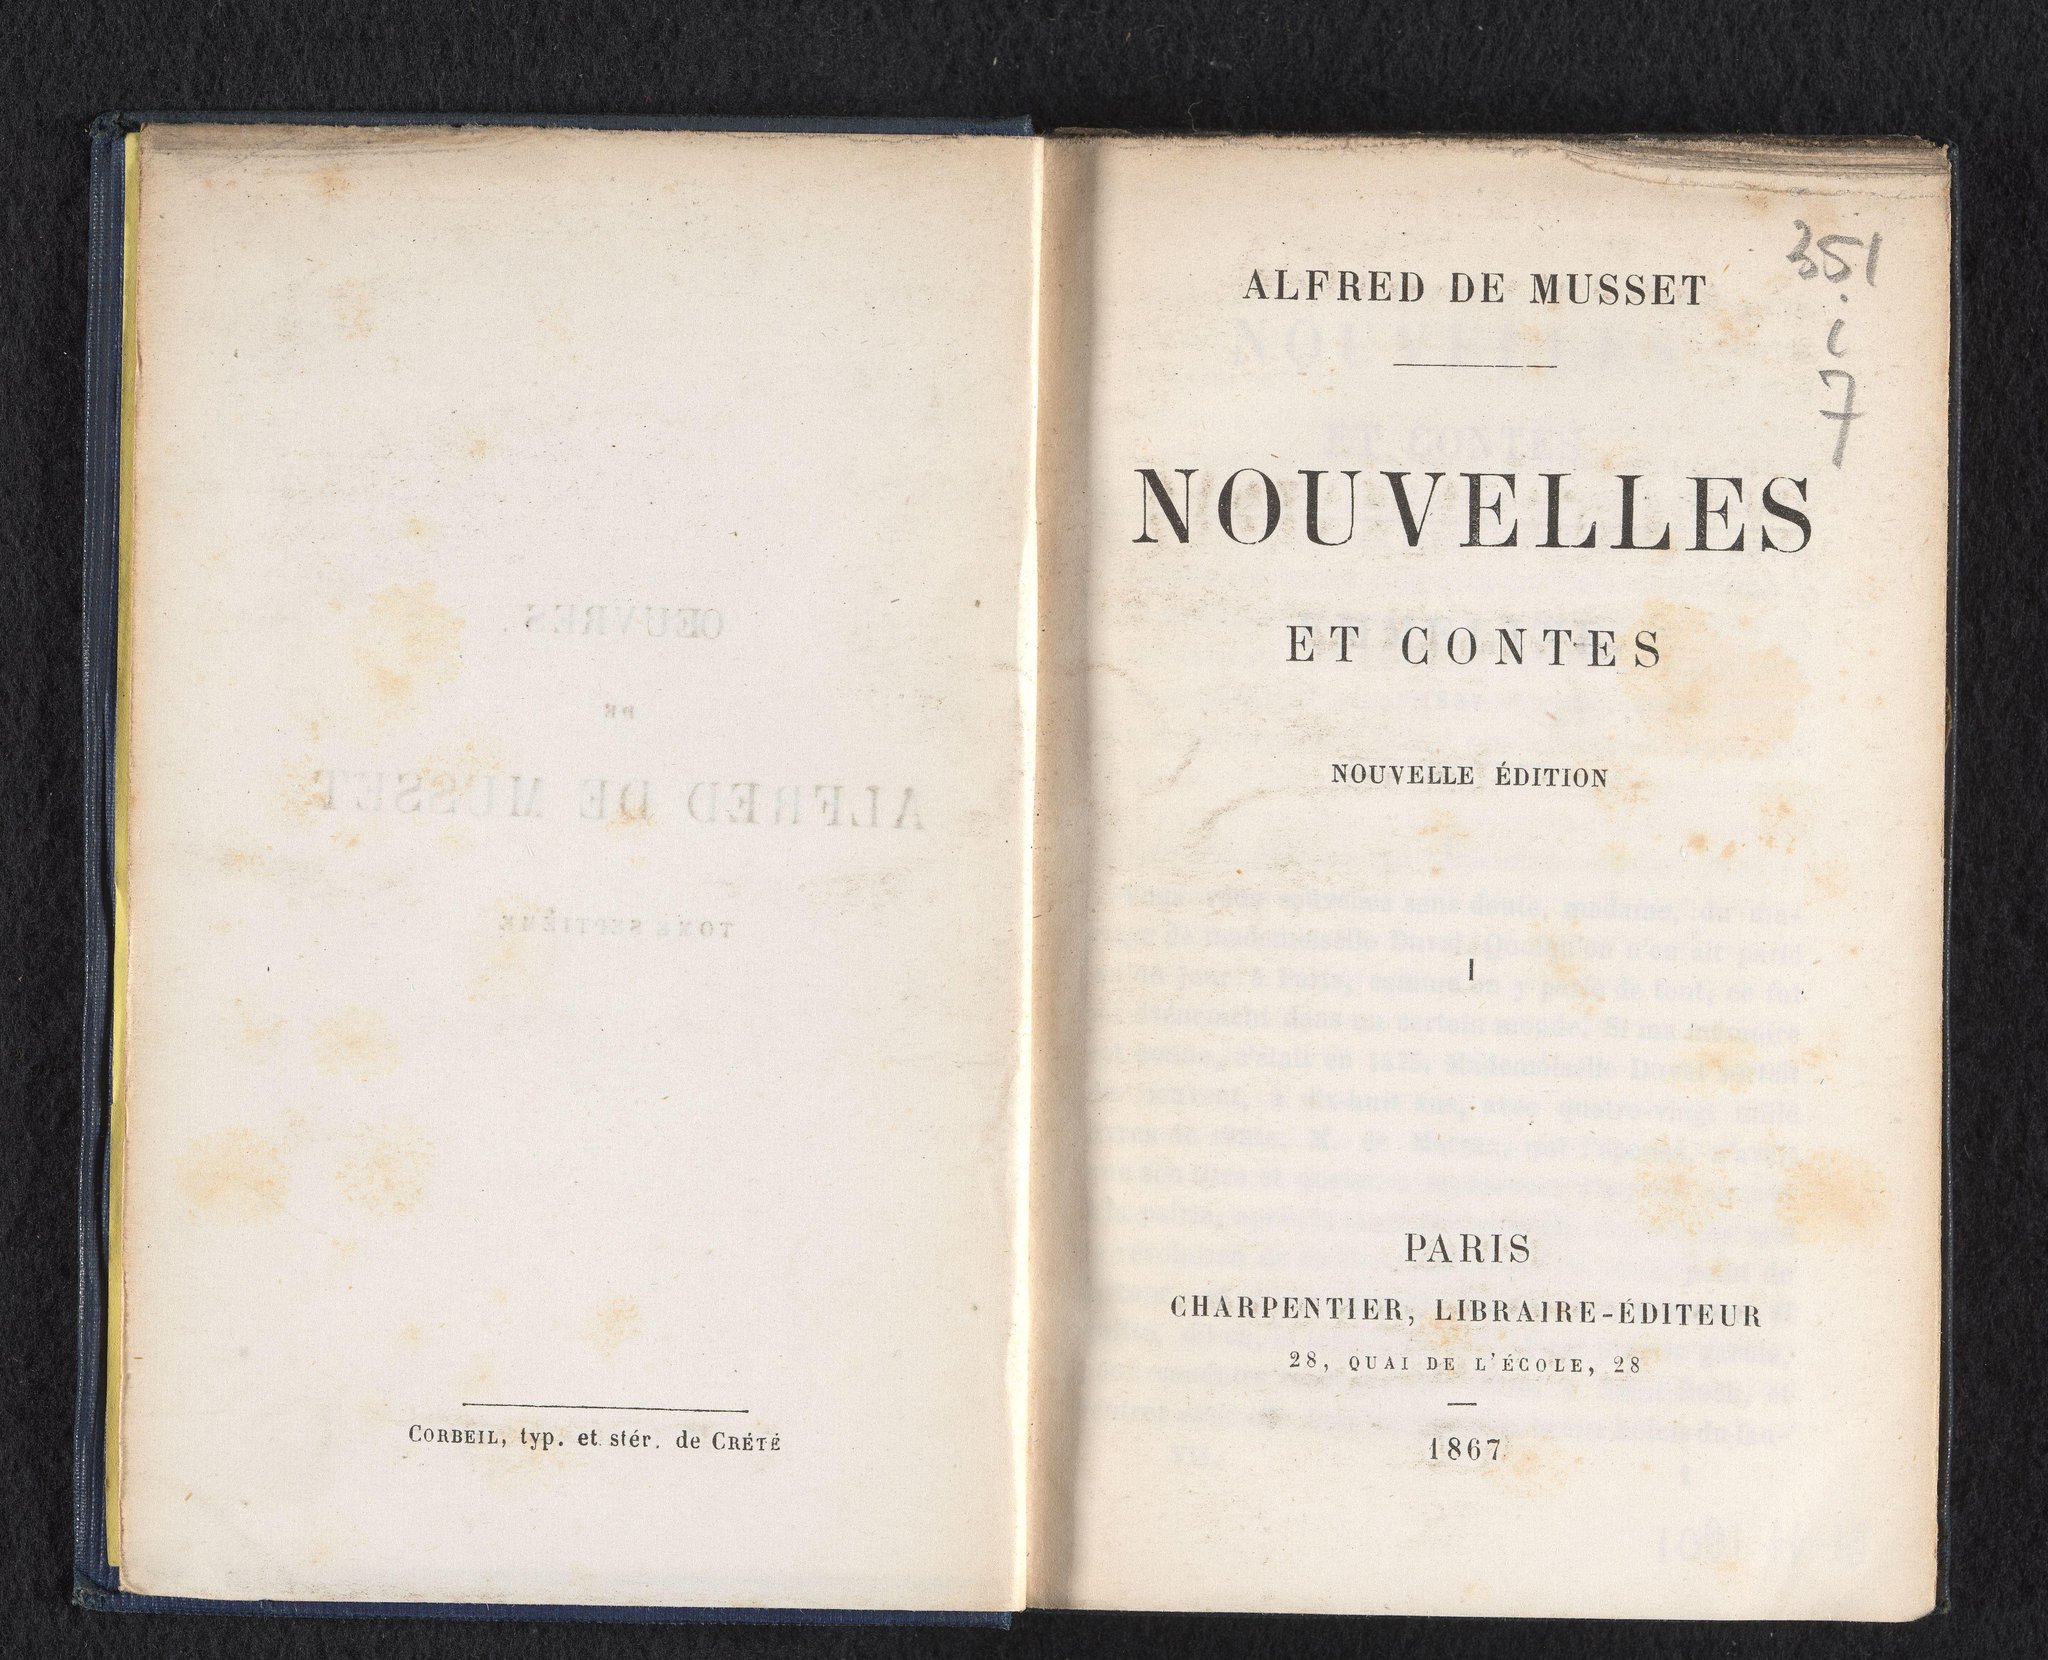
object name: book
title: Nouvelles et contes 1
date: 1867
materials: cardboard, paper, linen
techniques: albumen print, letterpress printing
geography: corbeil